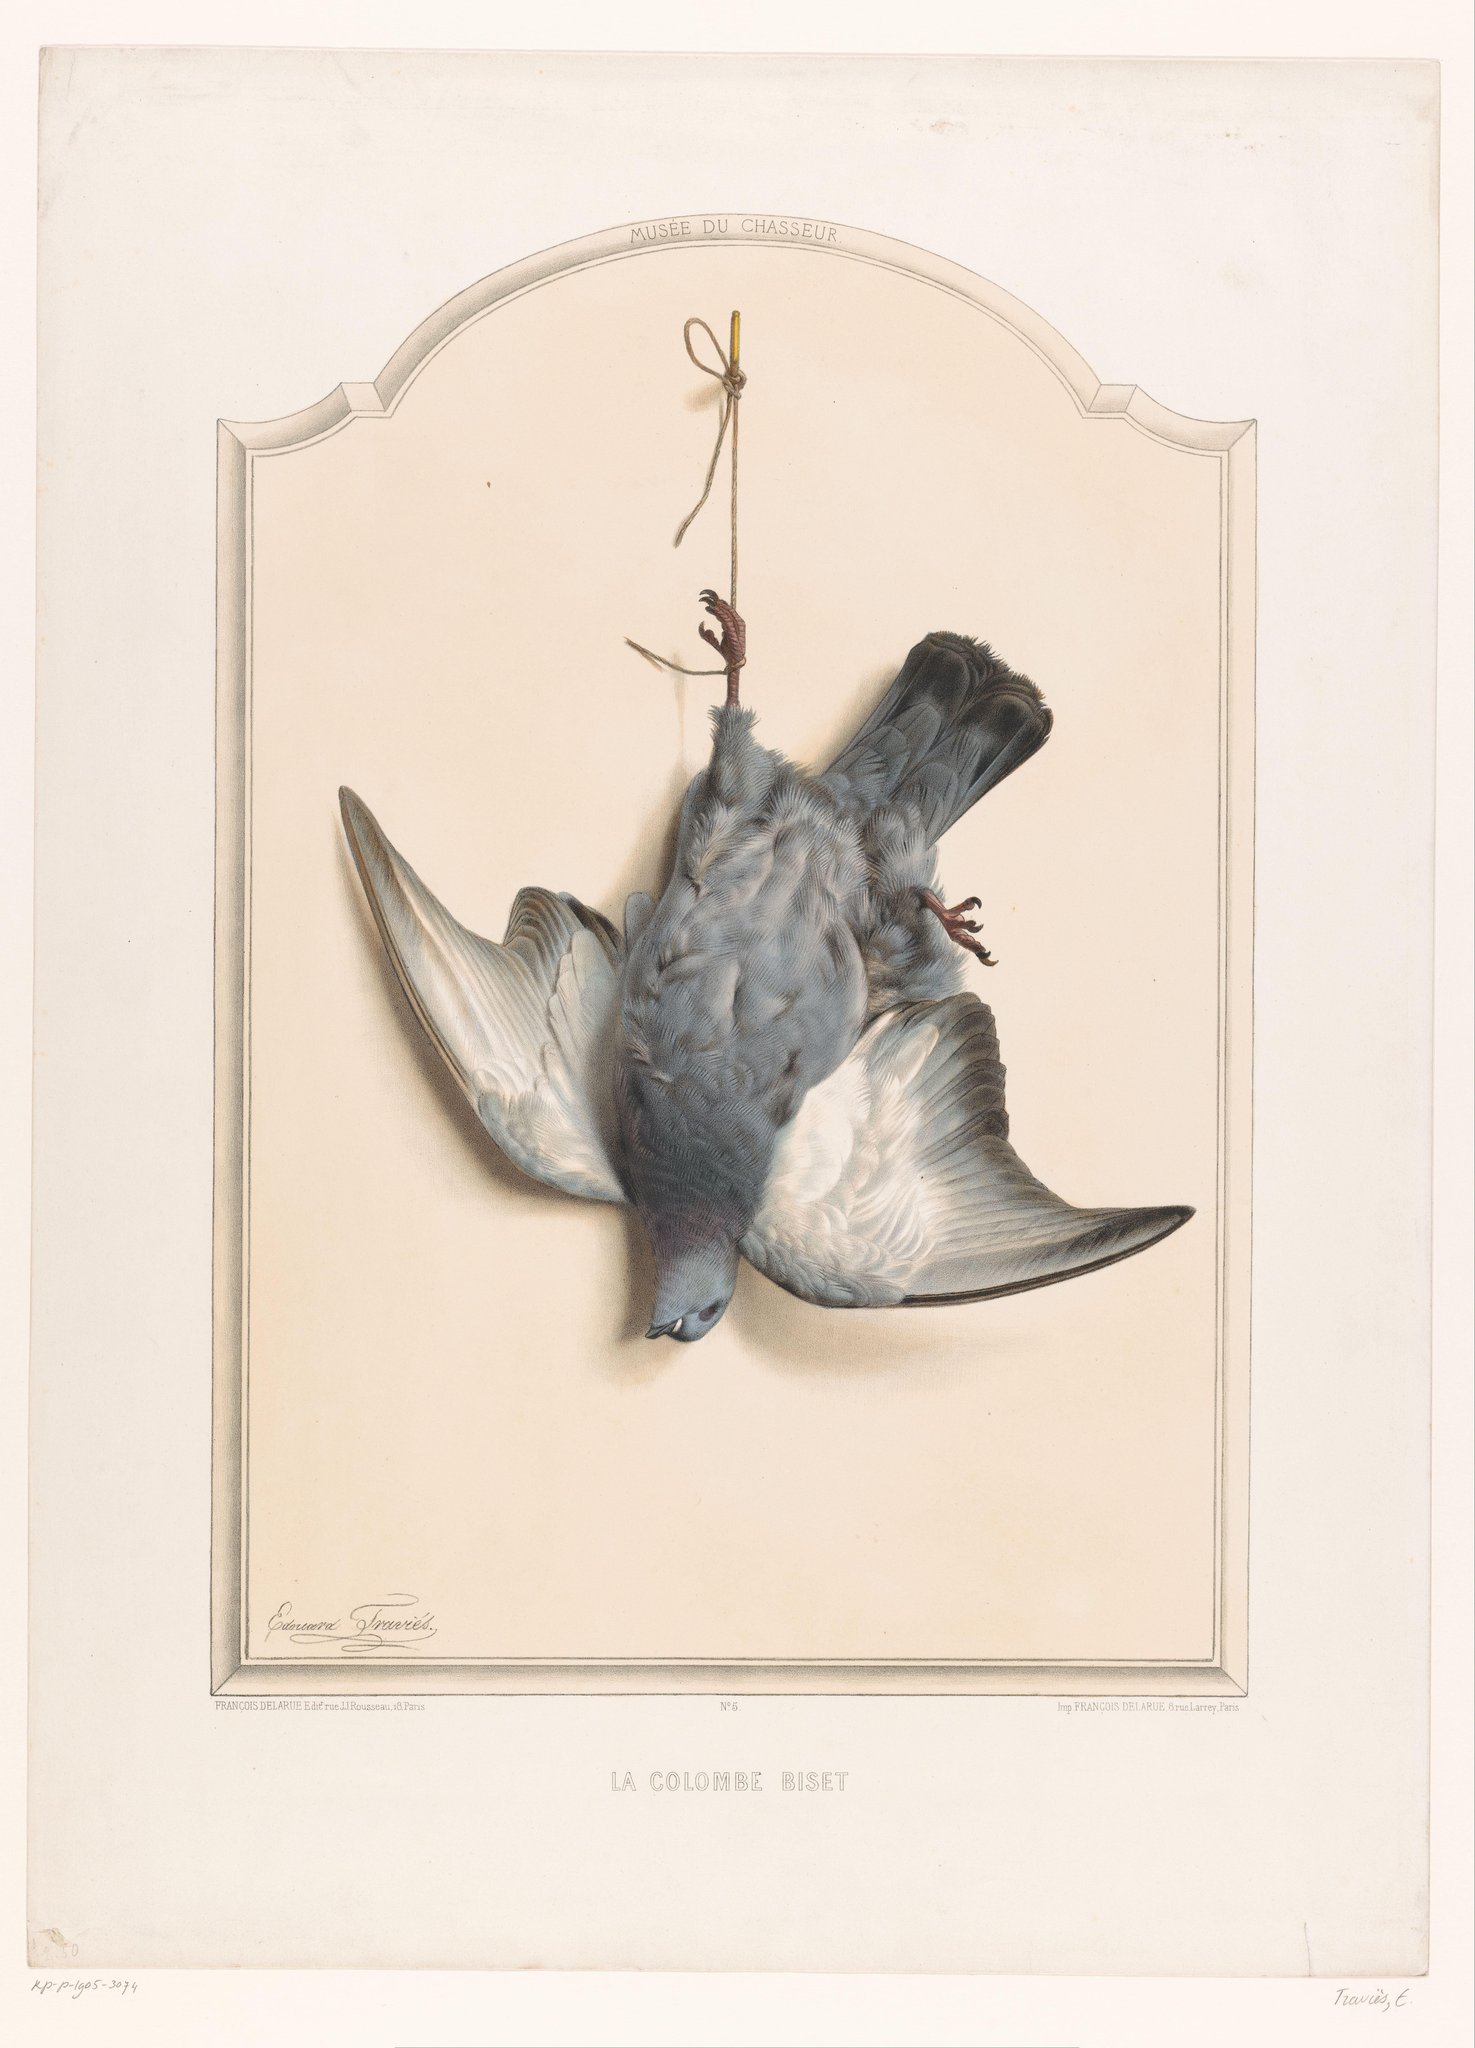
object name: print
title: Dode rotsduif hangend aan een poot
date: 1851-1870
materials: paper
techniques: lithograph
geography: paris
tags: bird hunting, doves, pigeons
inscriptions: collector's mark: Lugt 2228